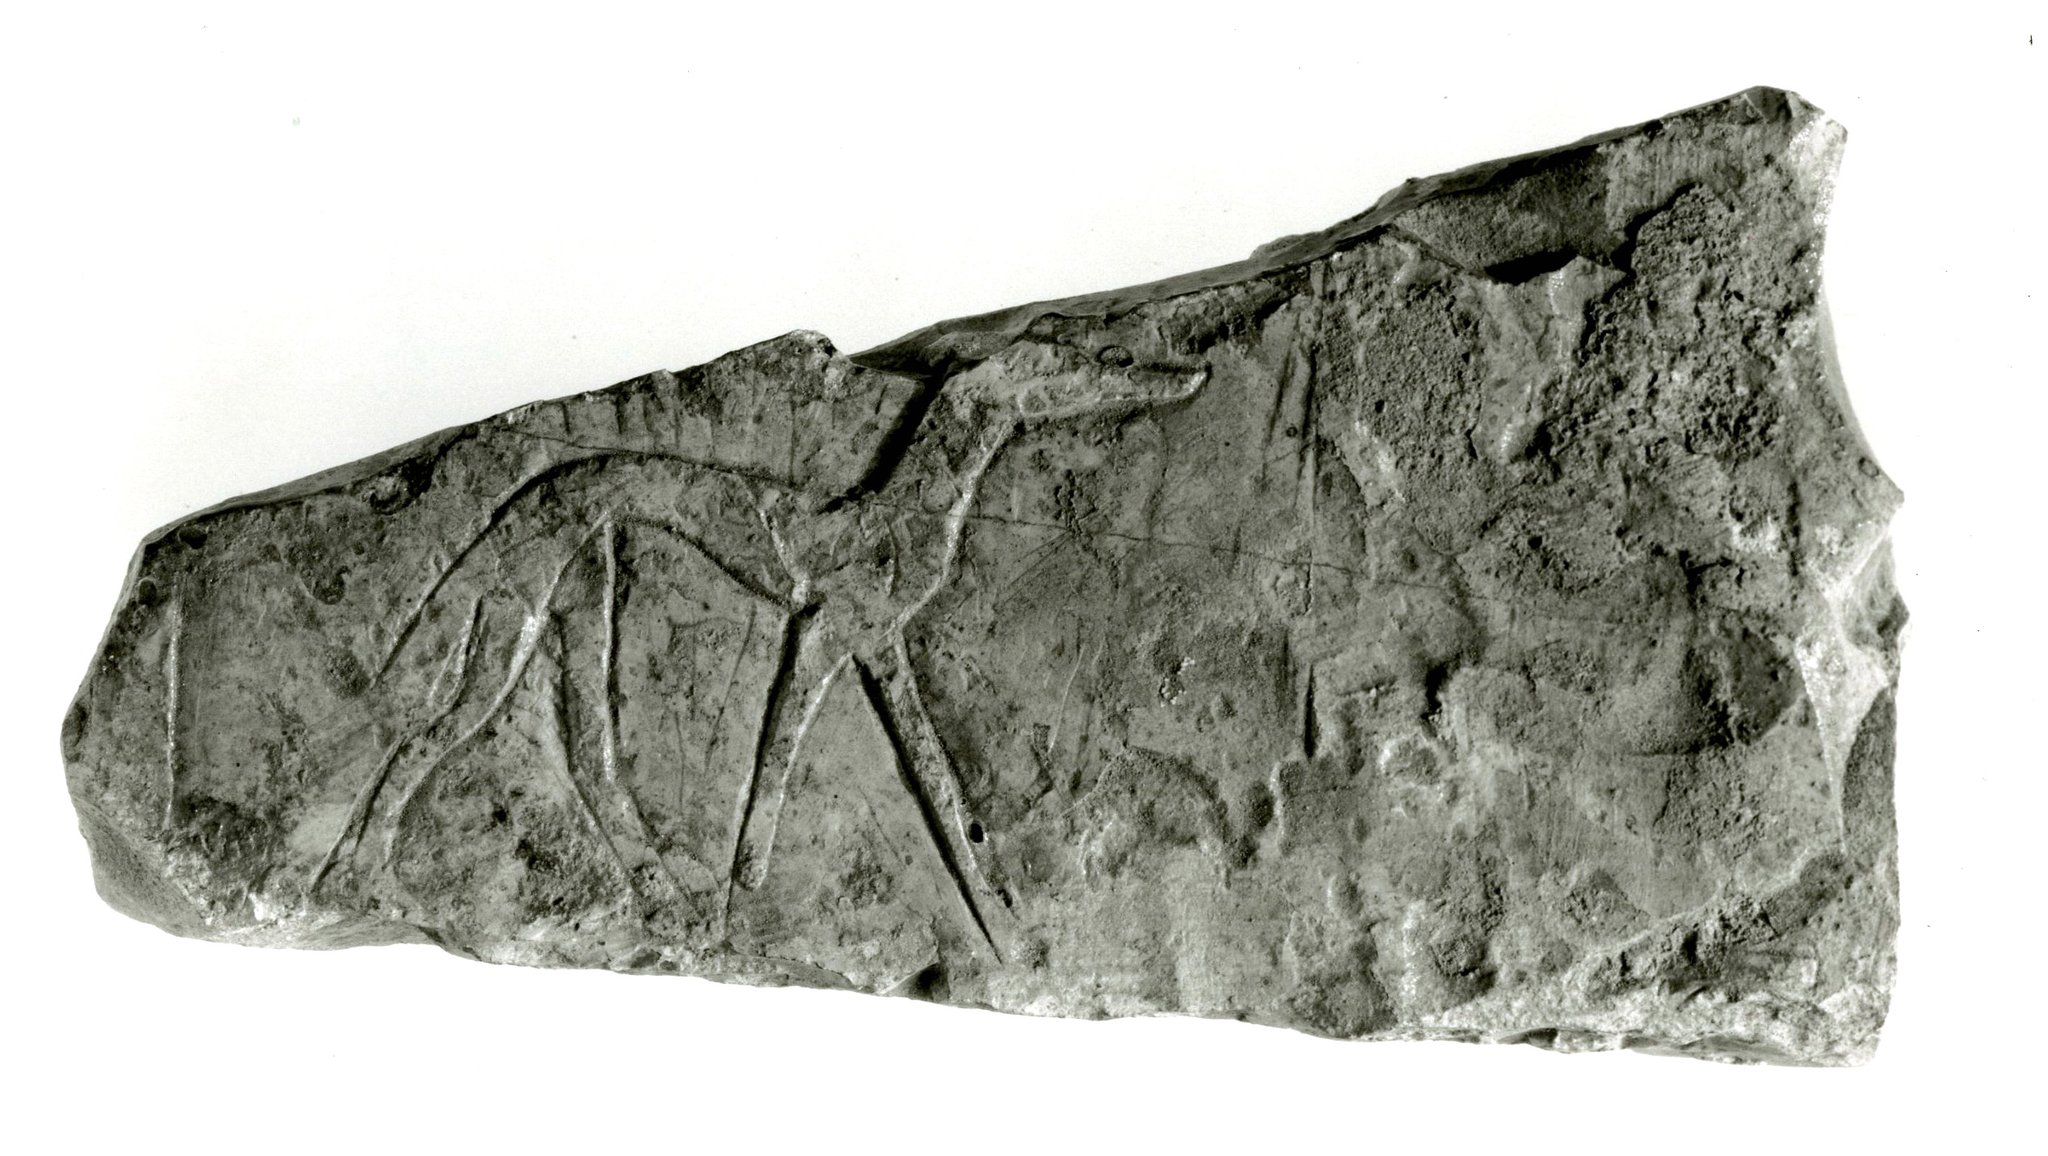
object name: relief, tomb of nespekashuty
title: Sunk relief fragment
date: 664-610 BCE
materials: limestone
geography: egypt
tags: animals